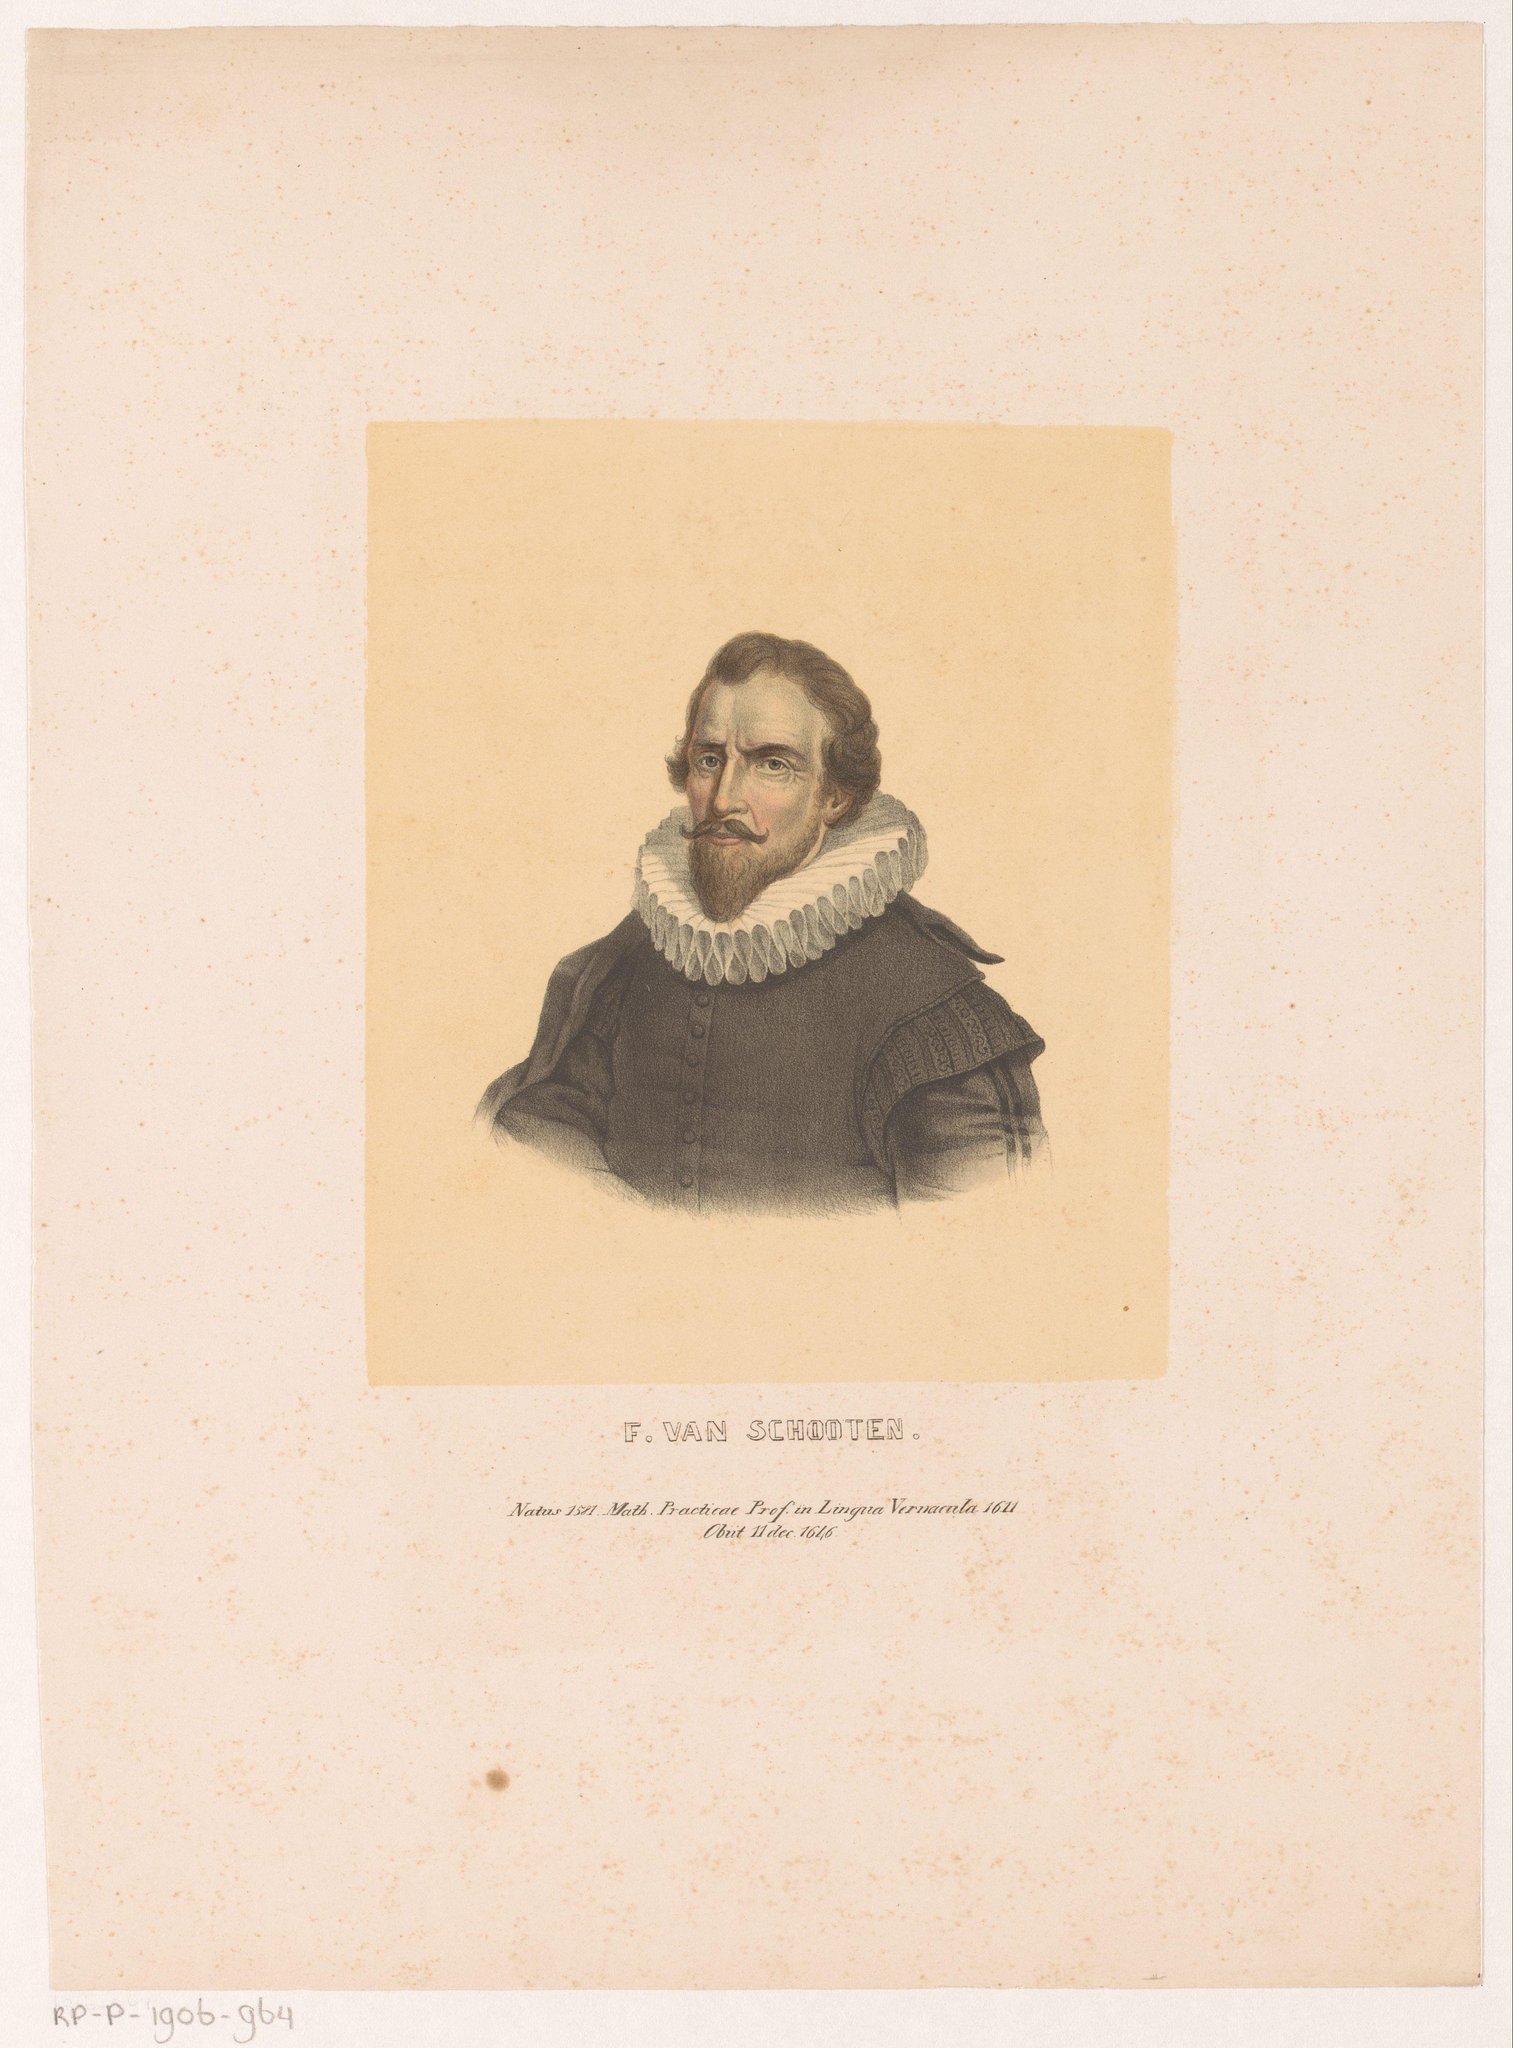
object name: print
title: F. van Schooten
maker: leendert springer (i)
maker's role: draughtsman, painter, print maker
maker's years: 1789-1871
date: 1850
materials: paper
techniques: lithograph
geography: leiden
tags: historical persons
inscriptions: collector's mark: Lugt 2228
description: Prent uit: Springer, Leendert. Galerij van hoogleeraren aan de Hoogeschool te Leijden, naar de oorspronkelijke afbeeldsels op de Senaat-zaal aldaar berustende. Leiden: Springer, Leendert., s.a. [circa 1850].